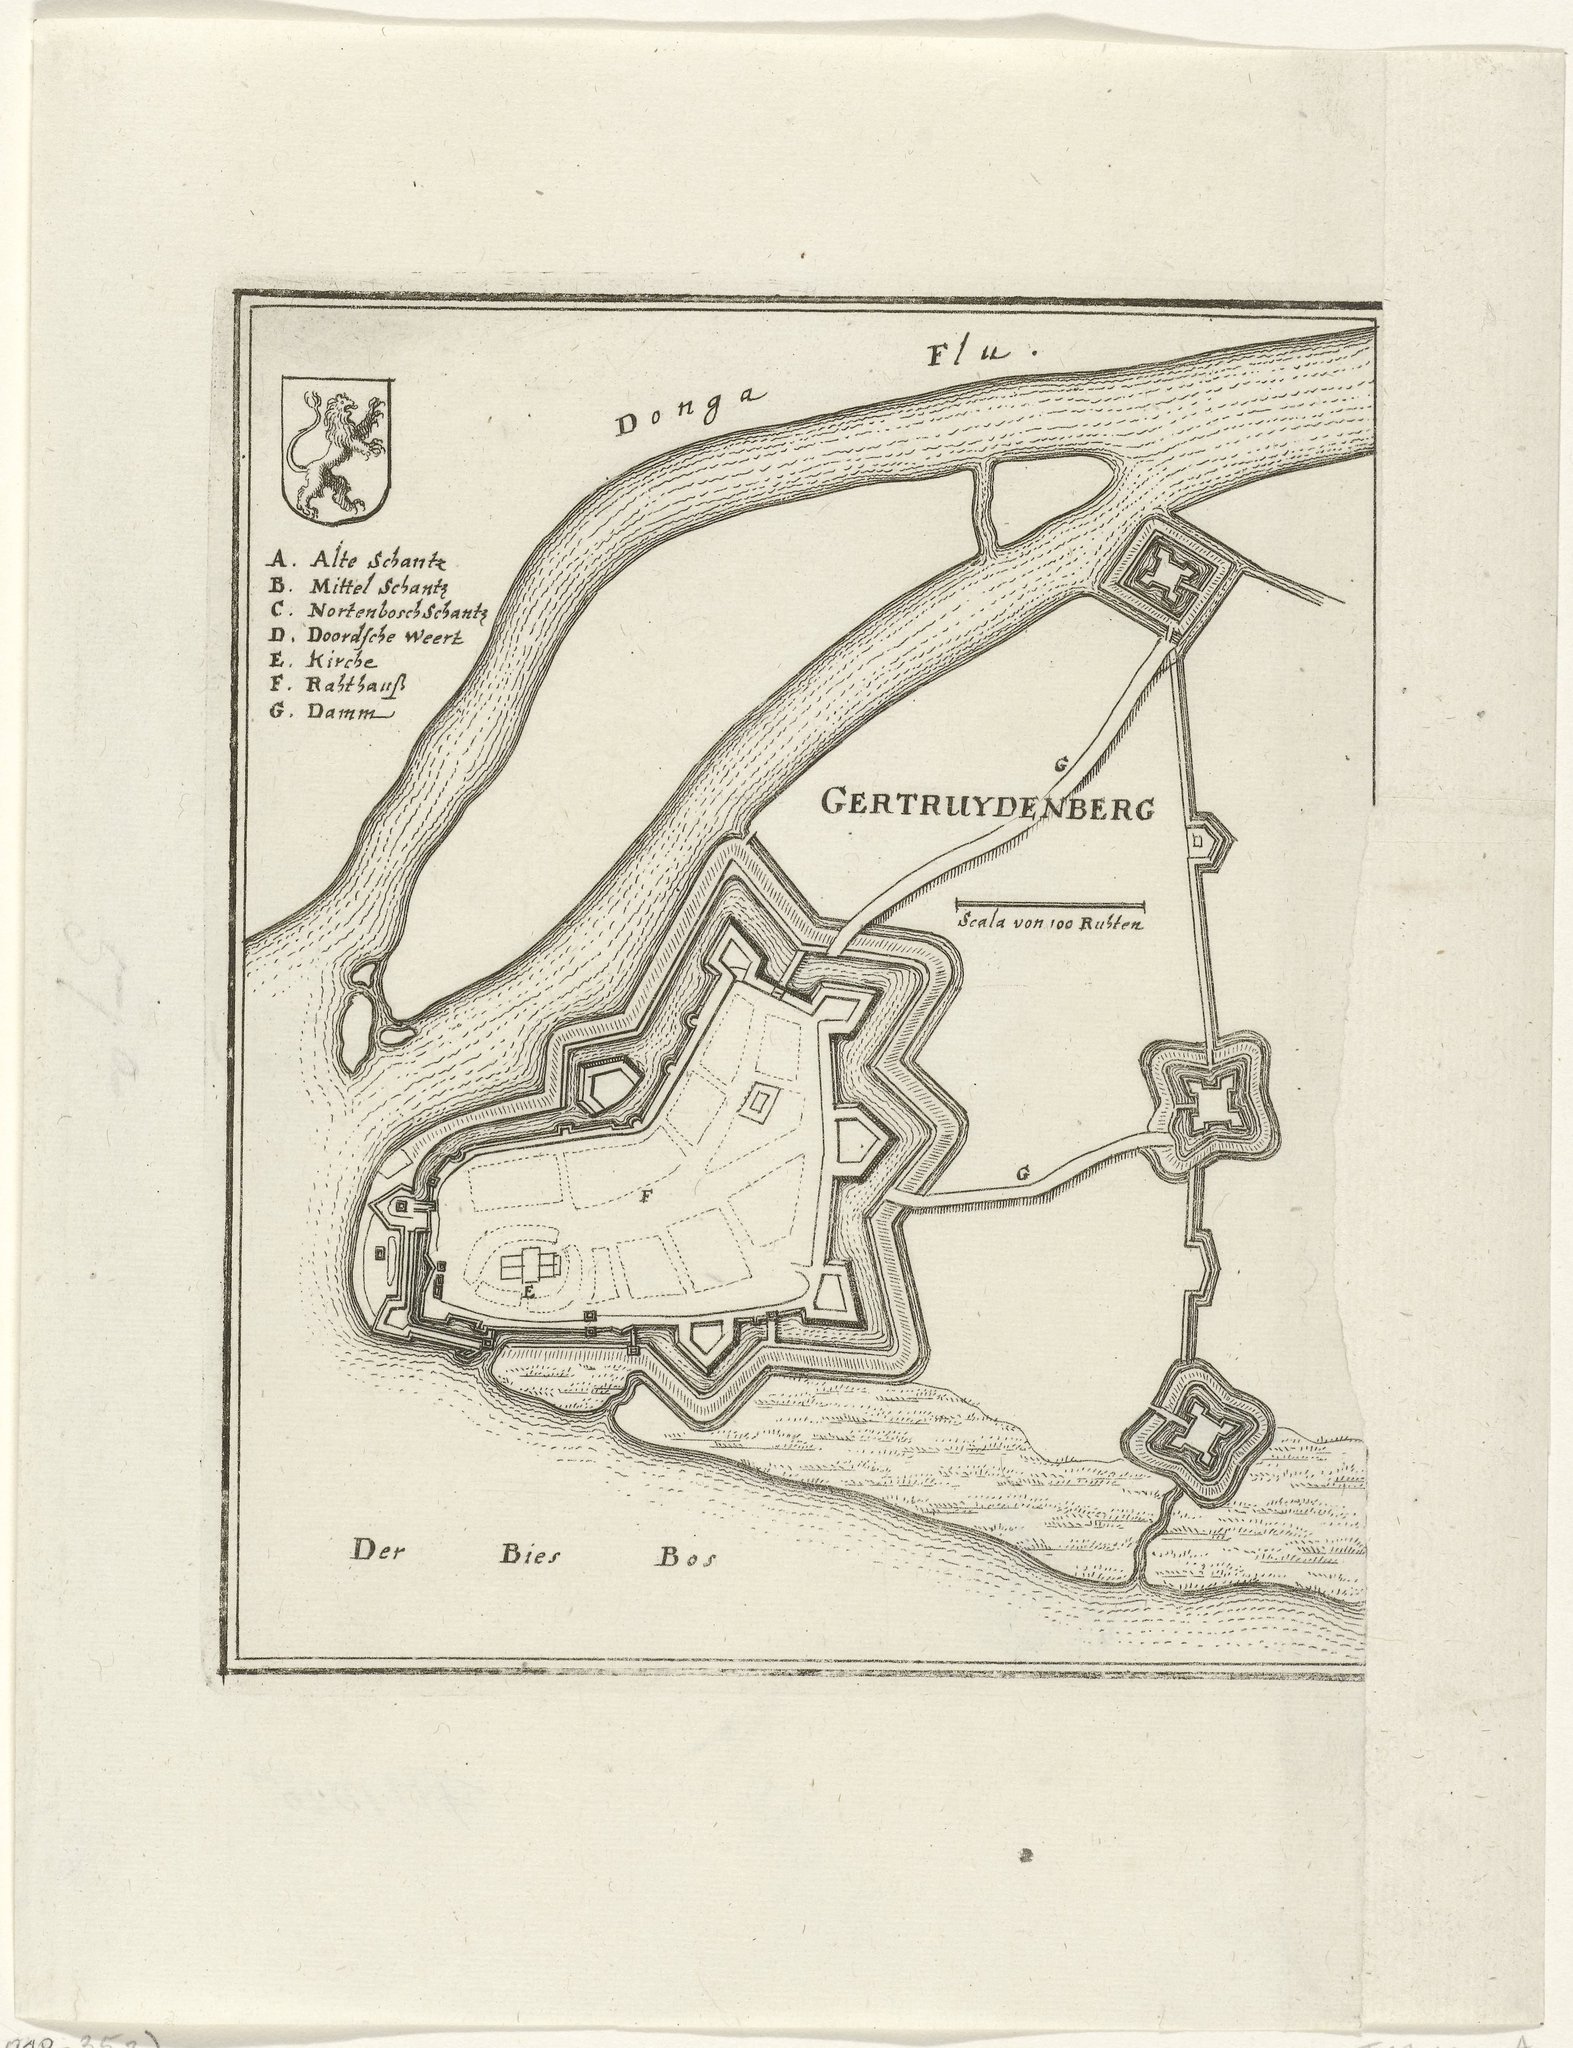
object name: history print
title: Vesting Geertruidenberg, 1593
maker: Anonymous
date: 1600-1699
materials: paper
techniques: etching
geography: germany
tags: the hague, maurice (prince of orange), siege, position war, maps of cities, geertruidenberg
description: Kaartje van Geertruidenberg aan de Donge met de schansen, ten tijde van het beleg door Maurits in 1593. Links de legenda A-G in het Duits.